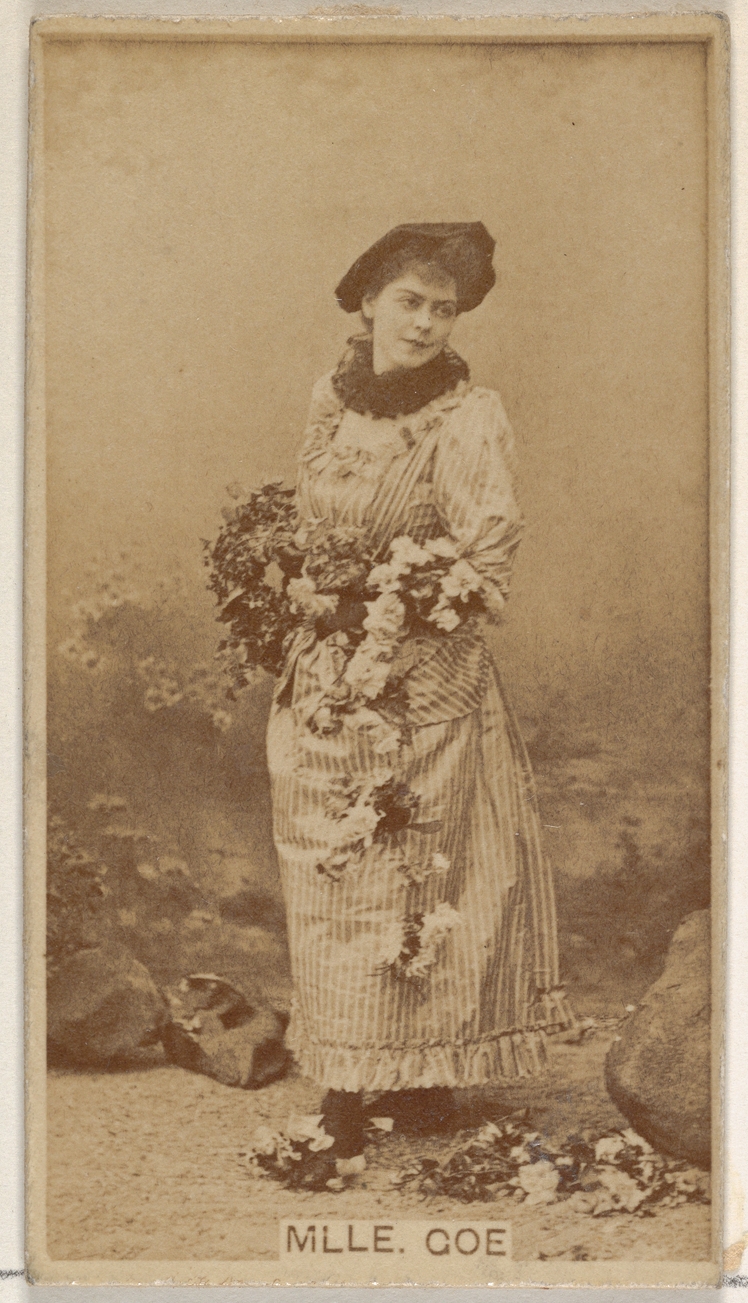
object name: photograph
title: Mlle. Coe, from the Actors and Actresses series (N45, Type 8) for Virginia Brights Cigarettes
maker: allen & ginter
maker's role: publisher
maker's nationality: american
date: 1888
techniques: albumen silver print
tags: portraits,women,actresses